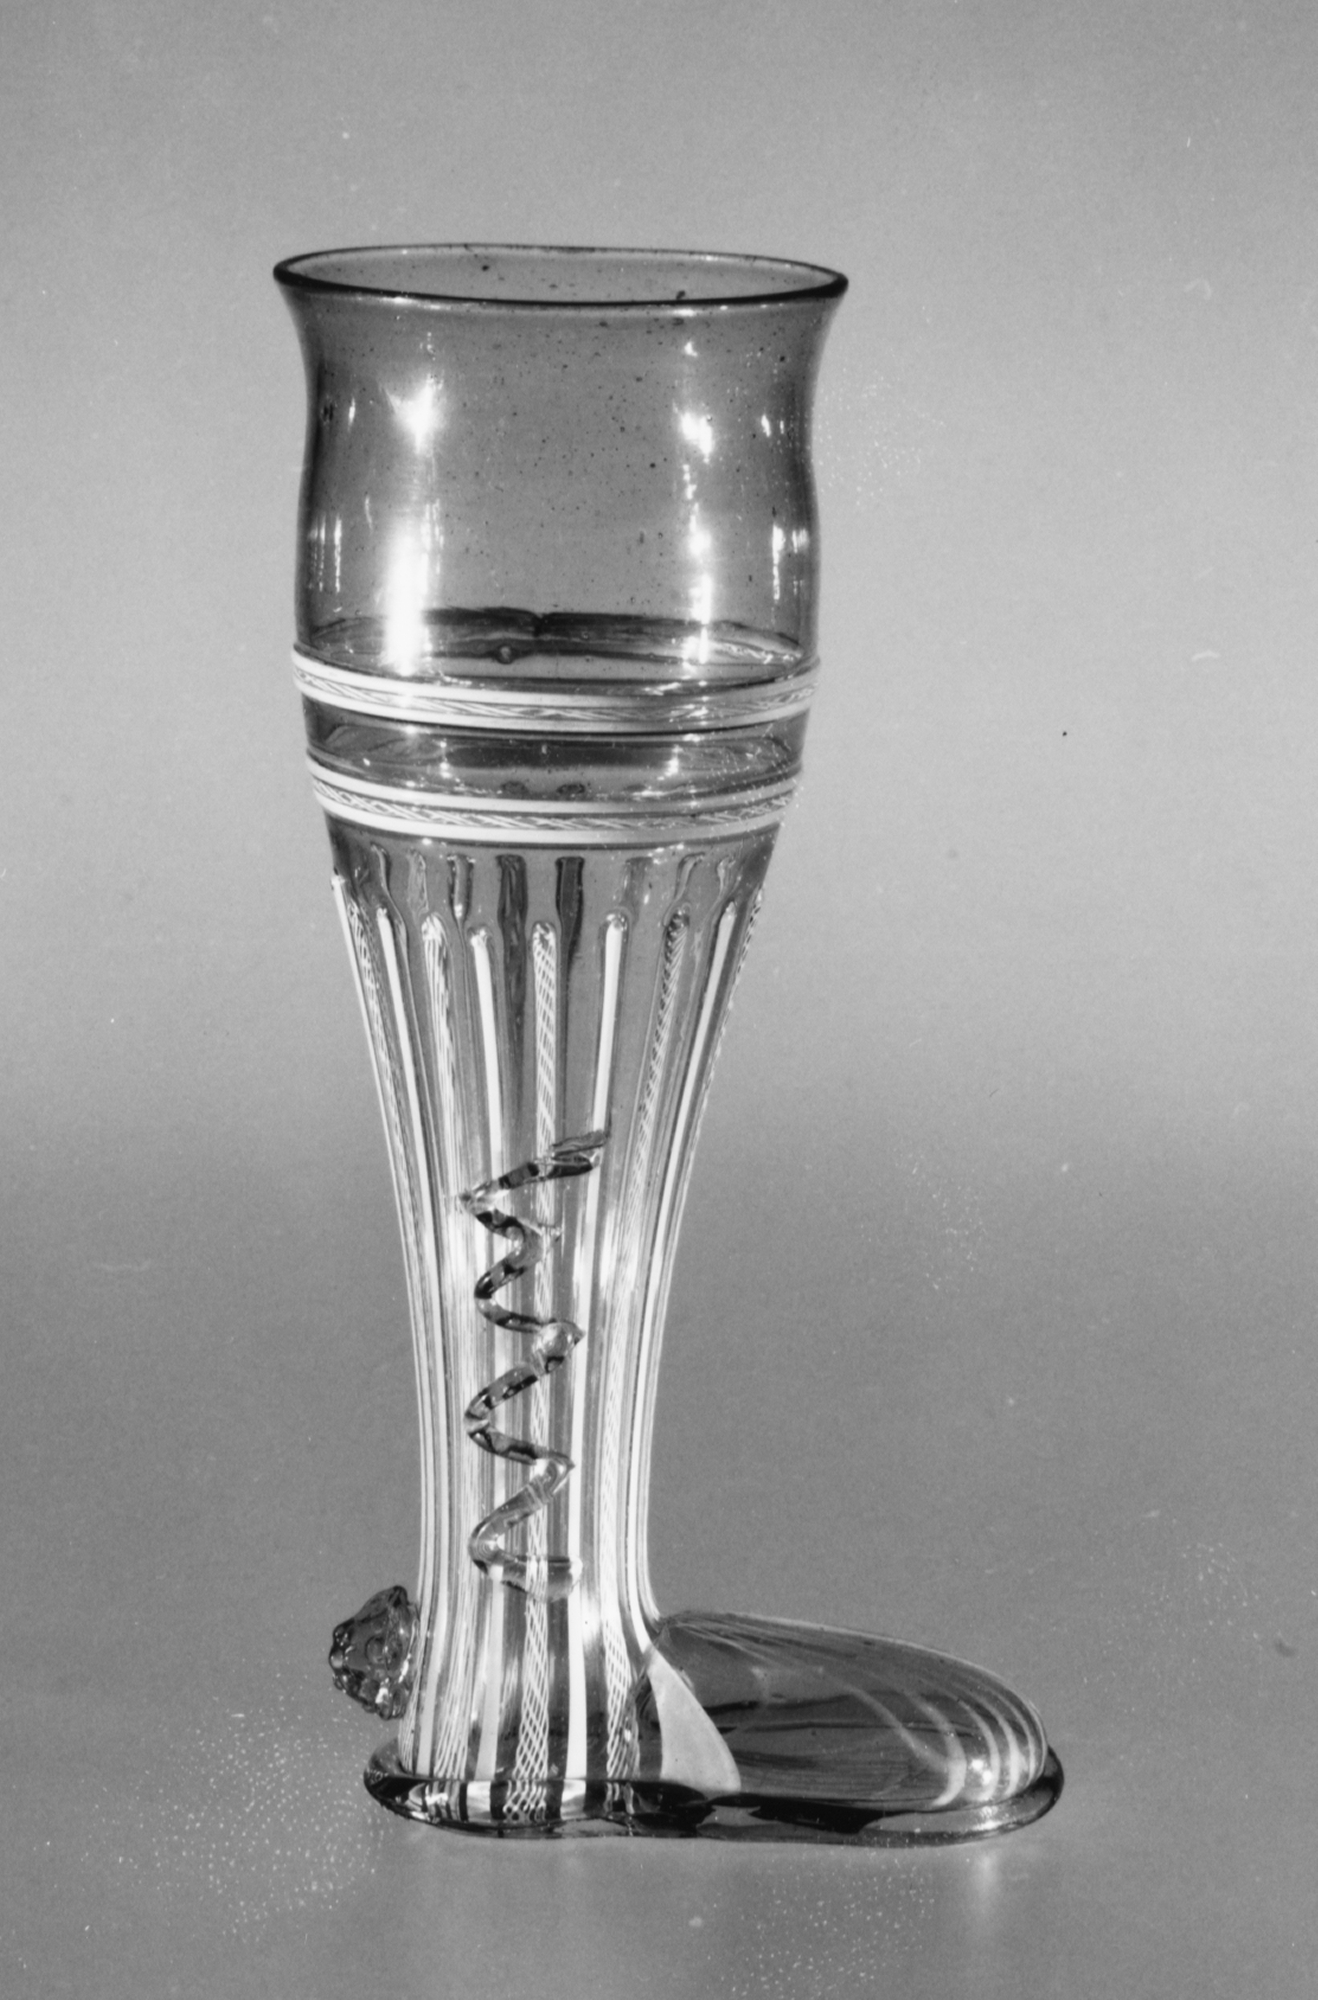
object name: glass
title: Boot glass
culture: venetian or façon de venise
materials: gilt, glass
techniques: glassblowing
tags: boots